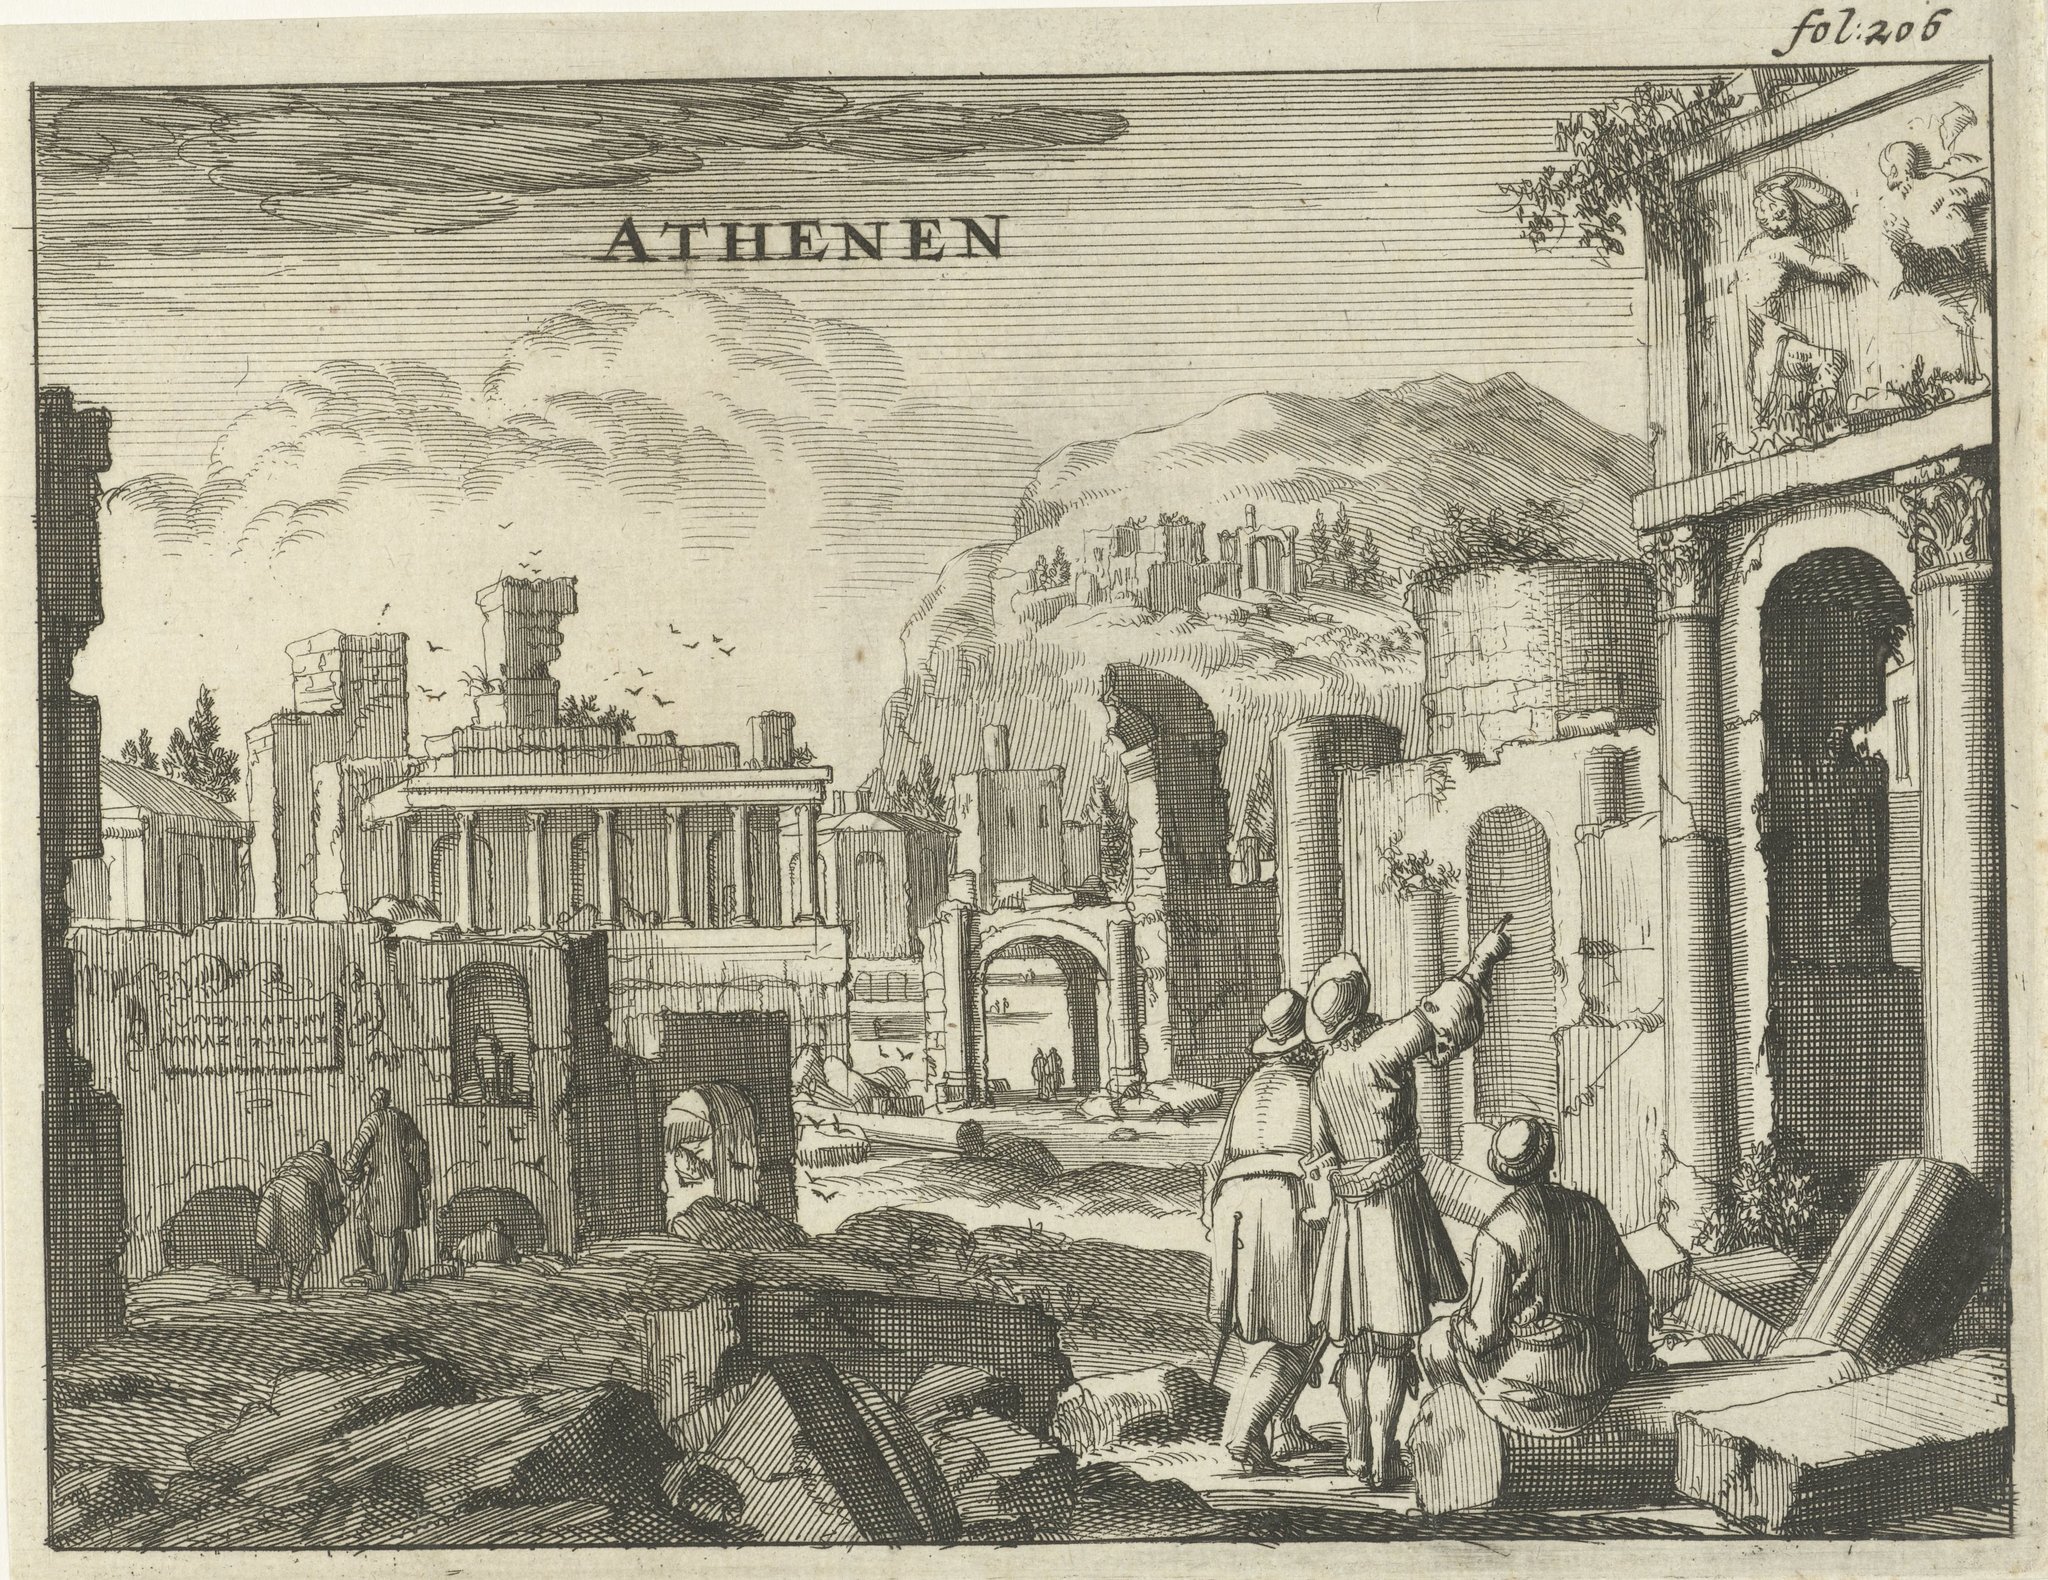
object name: print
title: Gezicht op Athene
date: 1689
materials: paper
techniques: etching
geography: amsterdam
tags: sightseeing, landscape with ruins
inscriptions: collector's mark: Lugt 2228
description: Illustratie uit: Spon, Jacob. Voyagie door Italien, Dalmatien, Grieckenland, en de Levant. Amsterdam: Jan Claesz ten Hoorn, 1689.